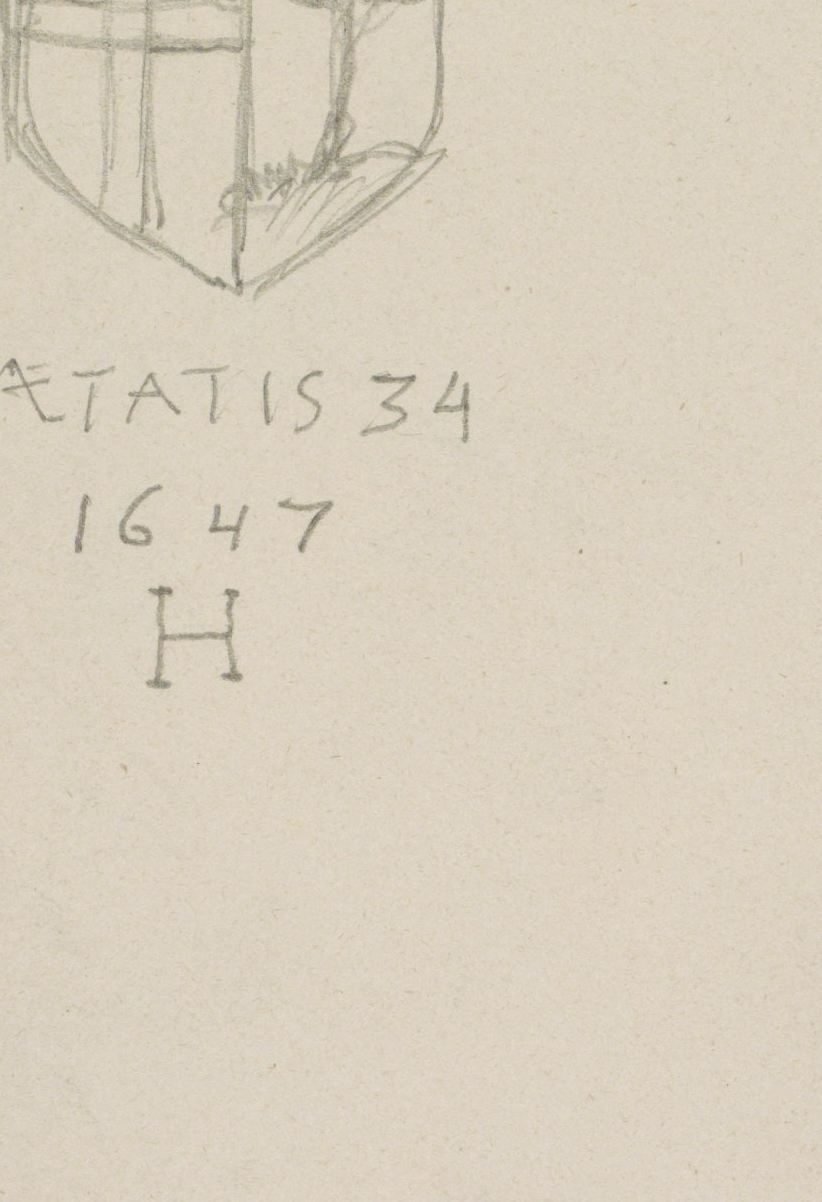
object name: sketchbook leaf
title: Wapen met kruis en boom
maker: george hendrik breitner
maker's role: draughtsman, painter, print maker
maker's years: 1857-1923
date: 1886-1908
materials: paper, pencil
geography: amsterdam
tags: coat of arms (symbol of sovereignty)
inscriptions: : ‘rood/ goud/ groen’, annotation: ‘AETATIS 34/ 1647/ H’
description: Pagina 9 uit een schetsboek met 46 bladen vervaardigd te Amsterdam, Haarlem en Antwerpen.